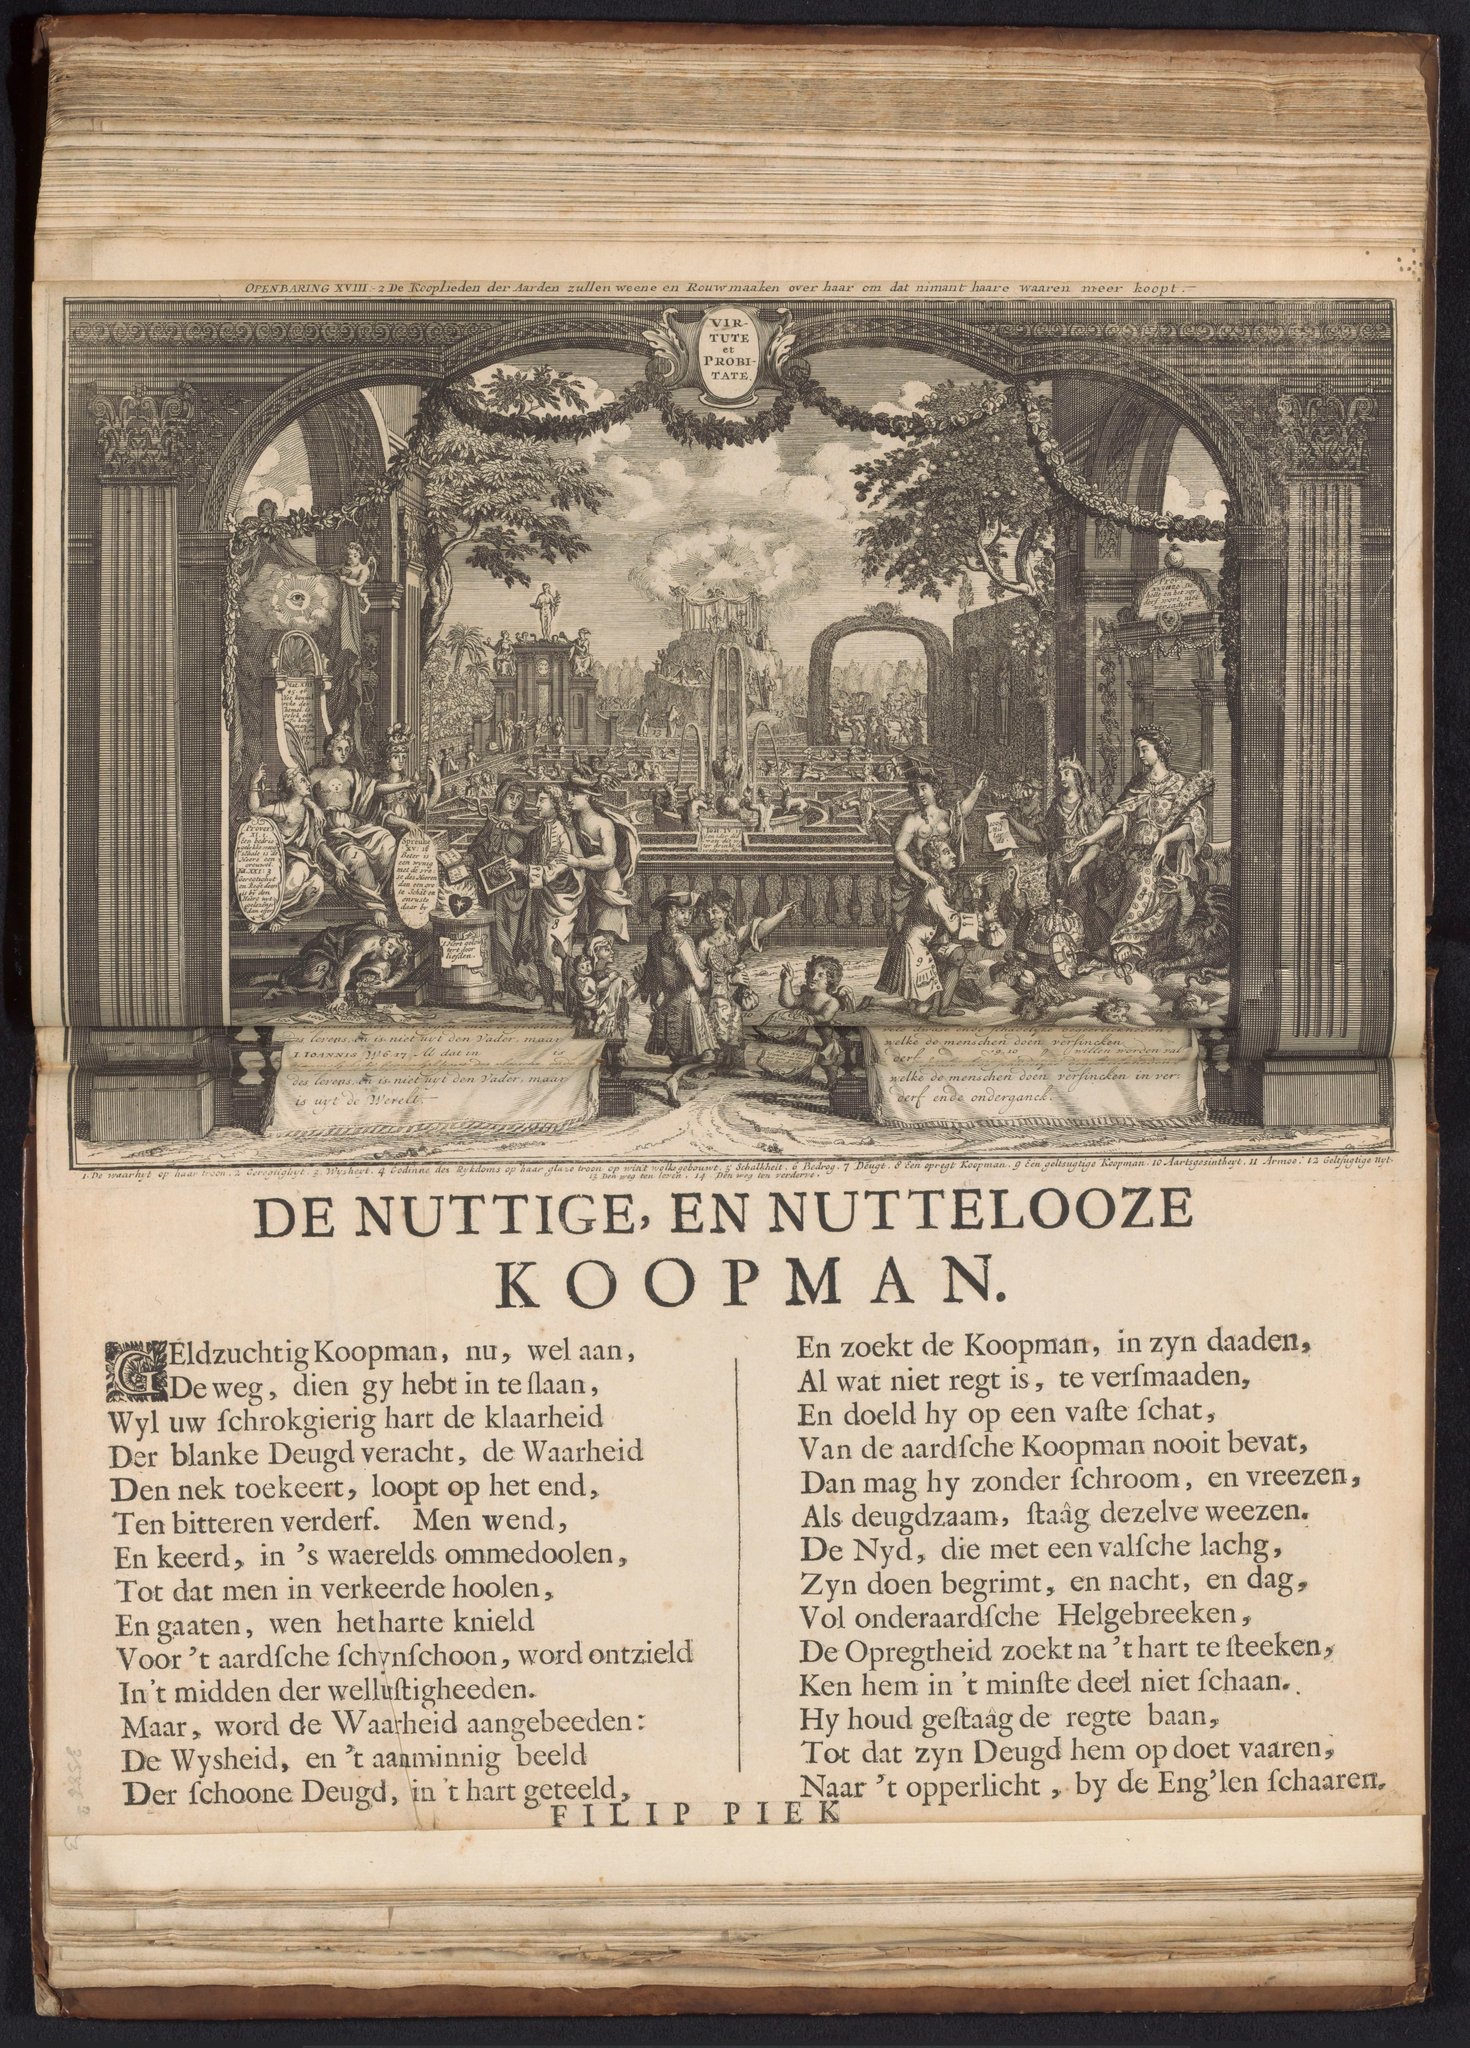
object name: print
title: De oprechte en de geldzuchtige koopman, 1720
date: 1720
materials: paper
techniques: engraving, etching, letterpress printing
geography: northern netherlands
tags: labyrinth, maze ~ garden, the way to destruction is broad and the gate is wide; the way to life is narrow and the gate is straight ~ doctrine of christ on love, etc. (matthew 7:13-14; luke 13:24), merchant, salesman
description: De oprechte en de geldzuchtige koopman. Links de oprechte koopman met Mercurius en Deugd voor de troon van de Waarheid, rechts de geldzuchtige koopman (de windhandelaar) met Bedrog en Schalkheid voor de troon van de Rijkdom. Op de balustrade bijbelcitaten. Op de achtergrond een tuin met een doolhof met de smalle en de brede weg. In het onderschrift de legenda 1-14 in het Nederlands. Apart gedrukt op het blad onder de plaat de titel en een vers van 2 kolommen. Prent in de gebonden eerste uitgave (304 B 11) van Het Groote Tafereel der Dwaasheid met spotprenten op de Windhandel of Actiehandel van 1720.